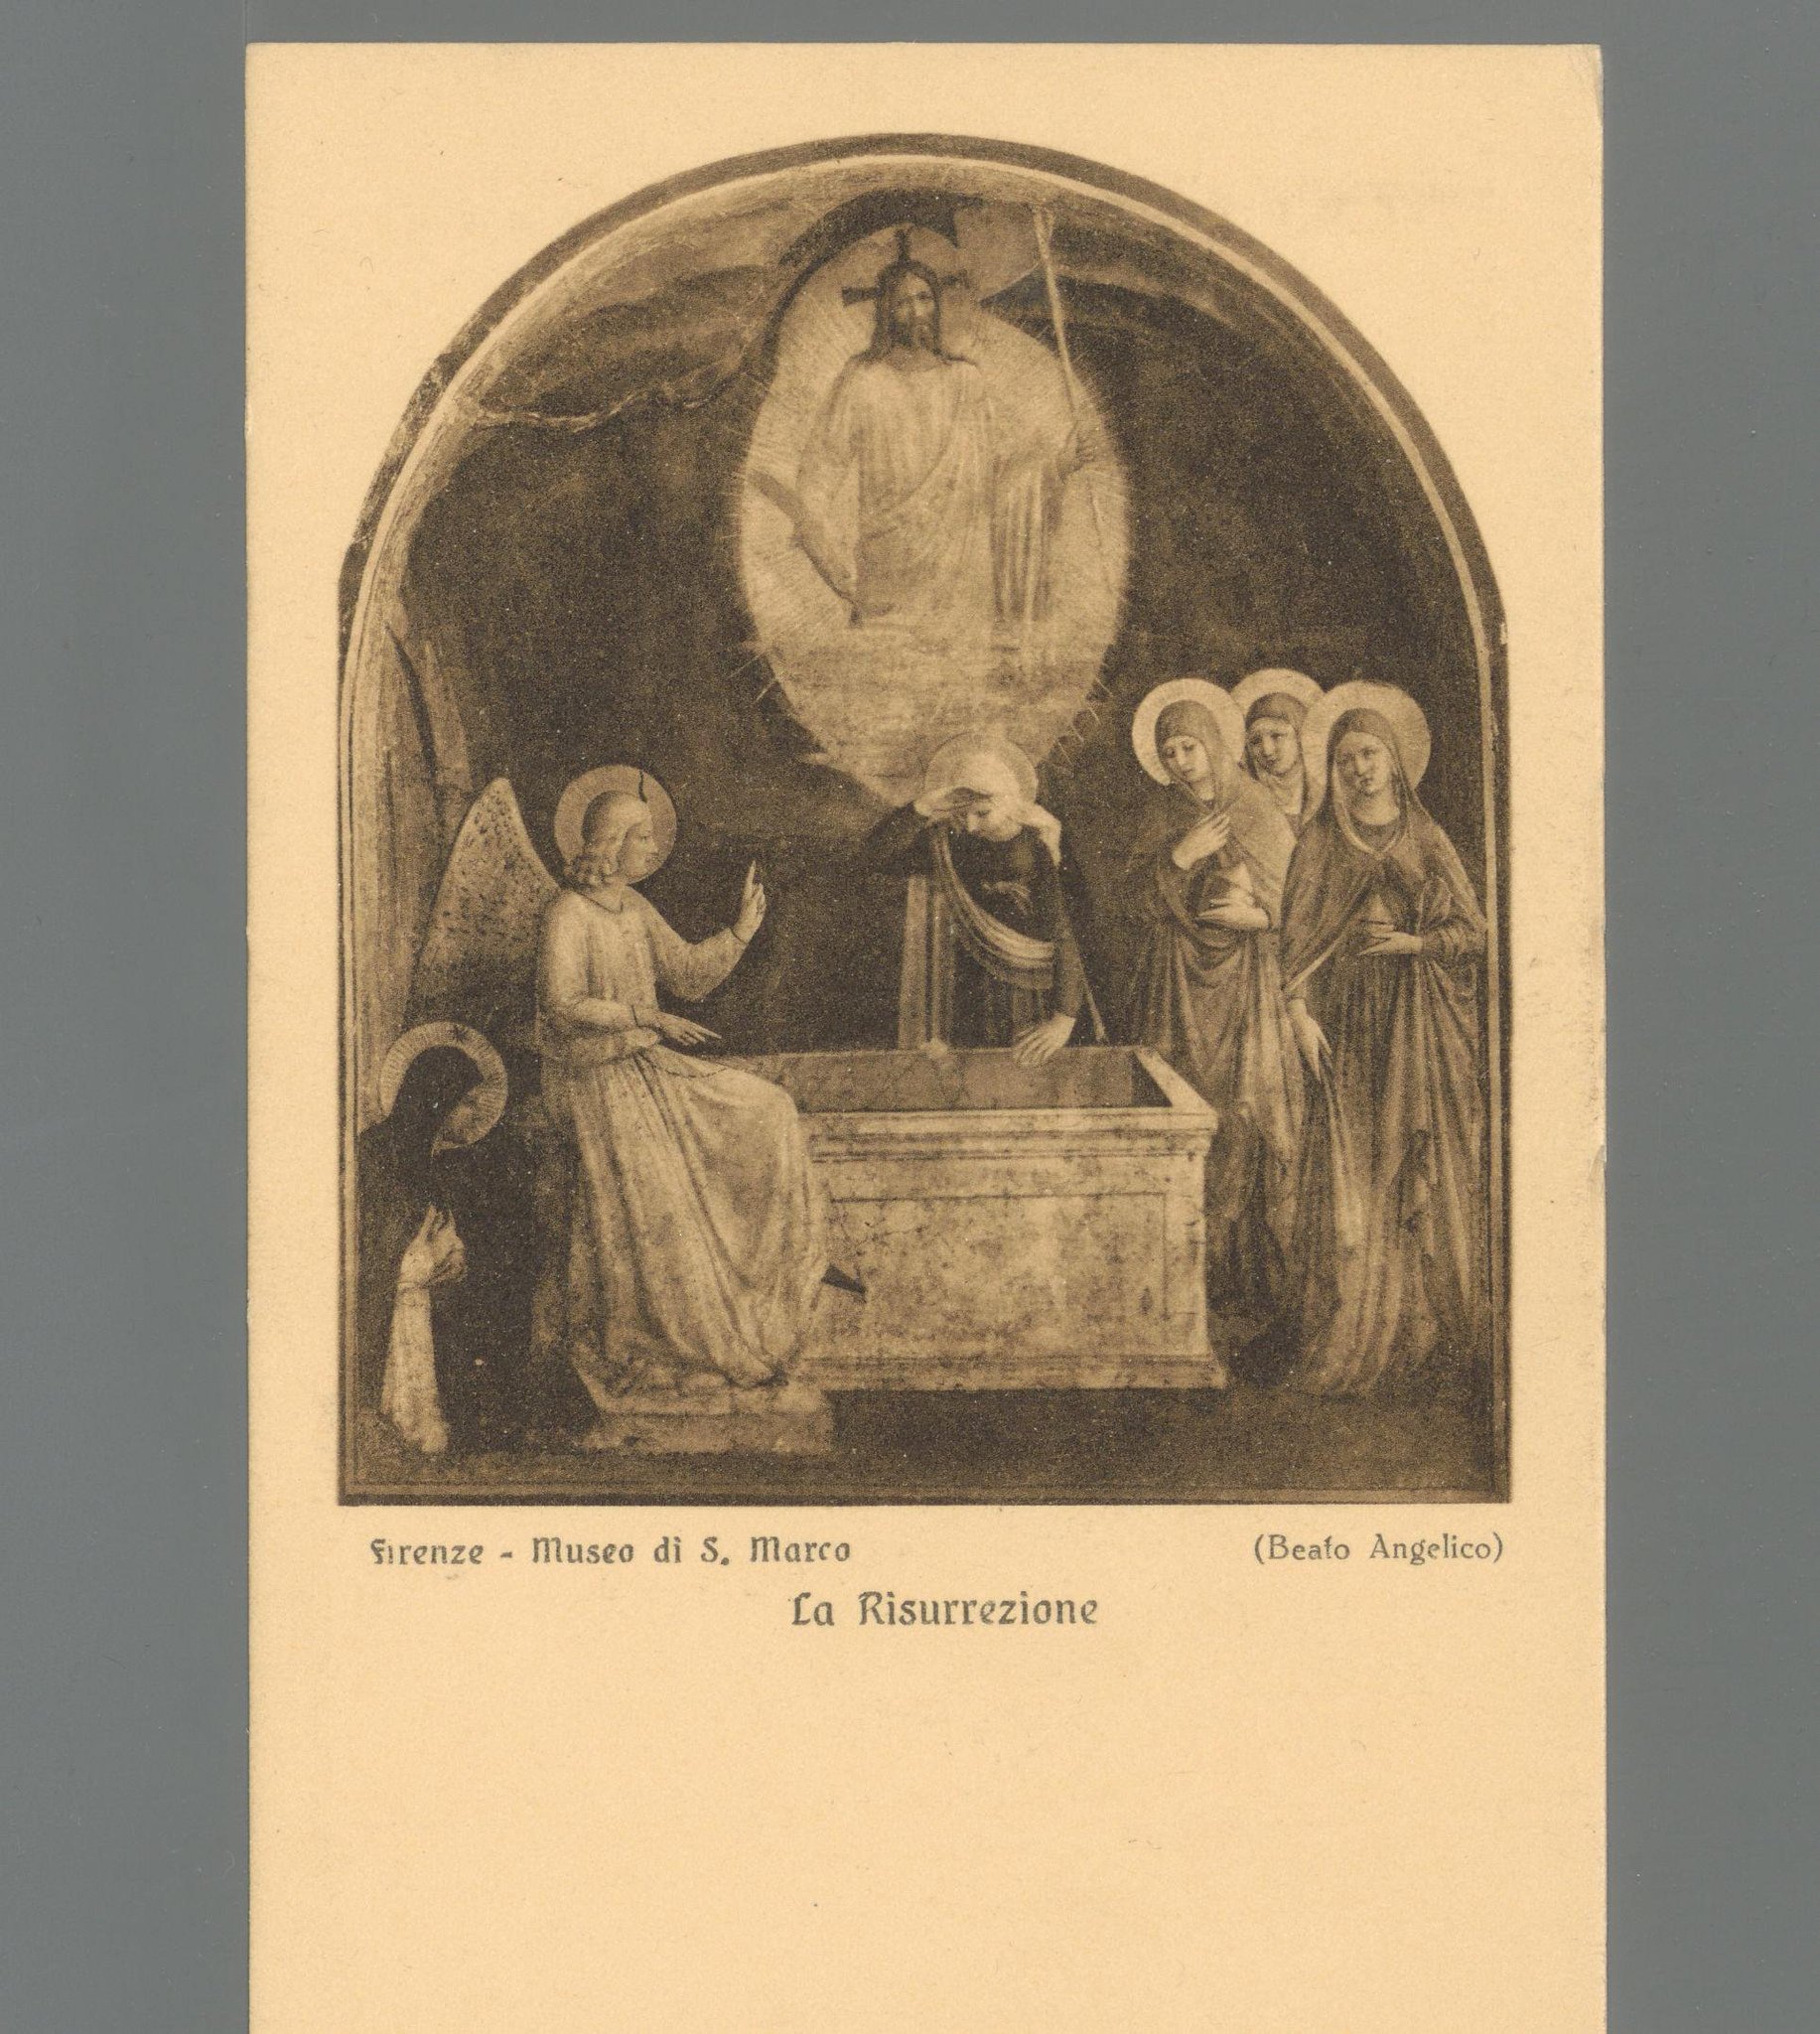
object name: reproduction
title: Firenze - Museo di S. Marco. La Risurrezione (Beato Angelico)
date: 1906-1930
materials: cardboard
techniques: photograph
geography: como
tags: permanent exhibition, museum, picture, painting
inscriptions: collector's mark: ‘AFE v S’